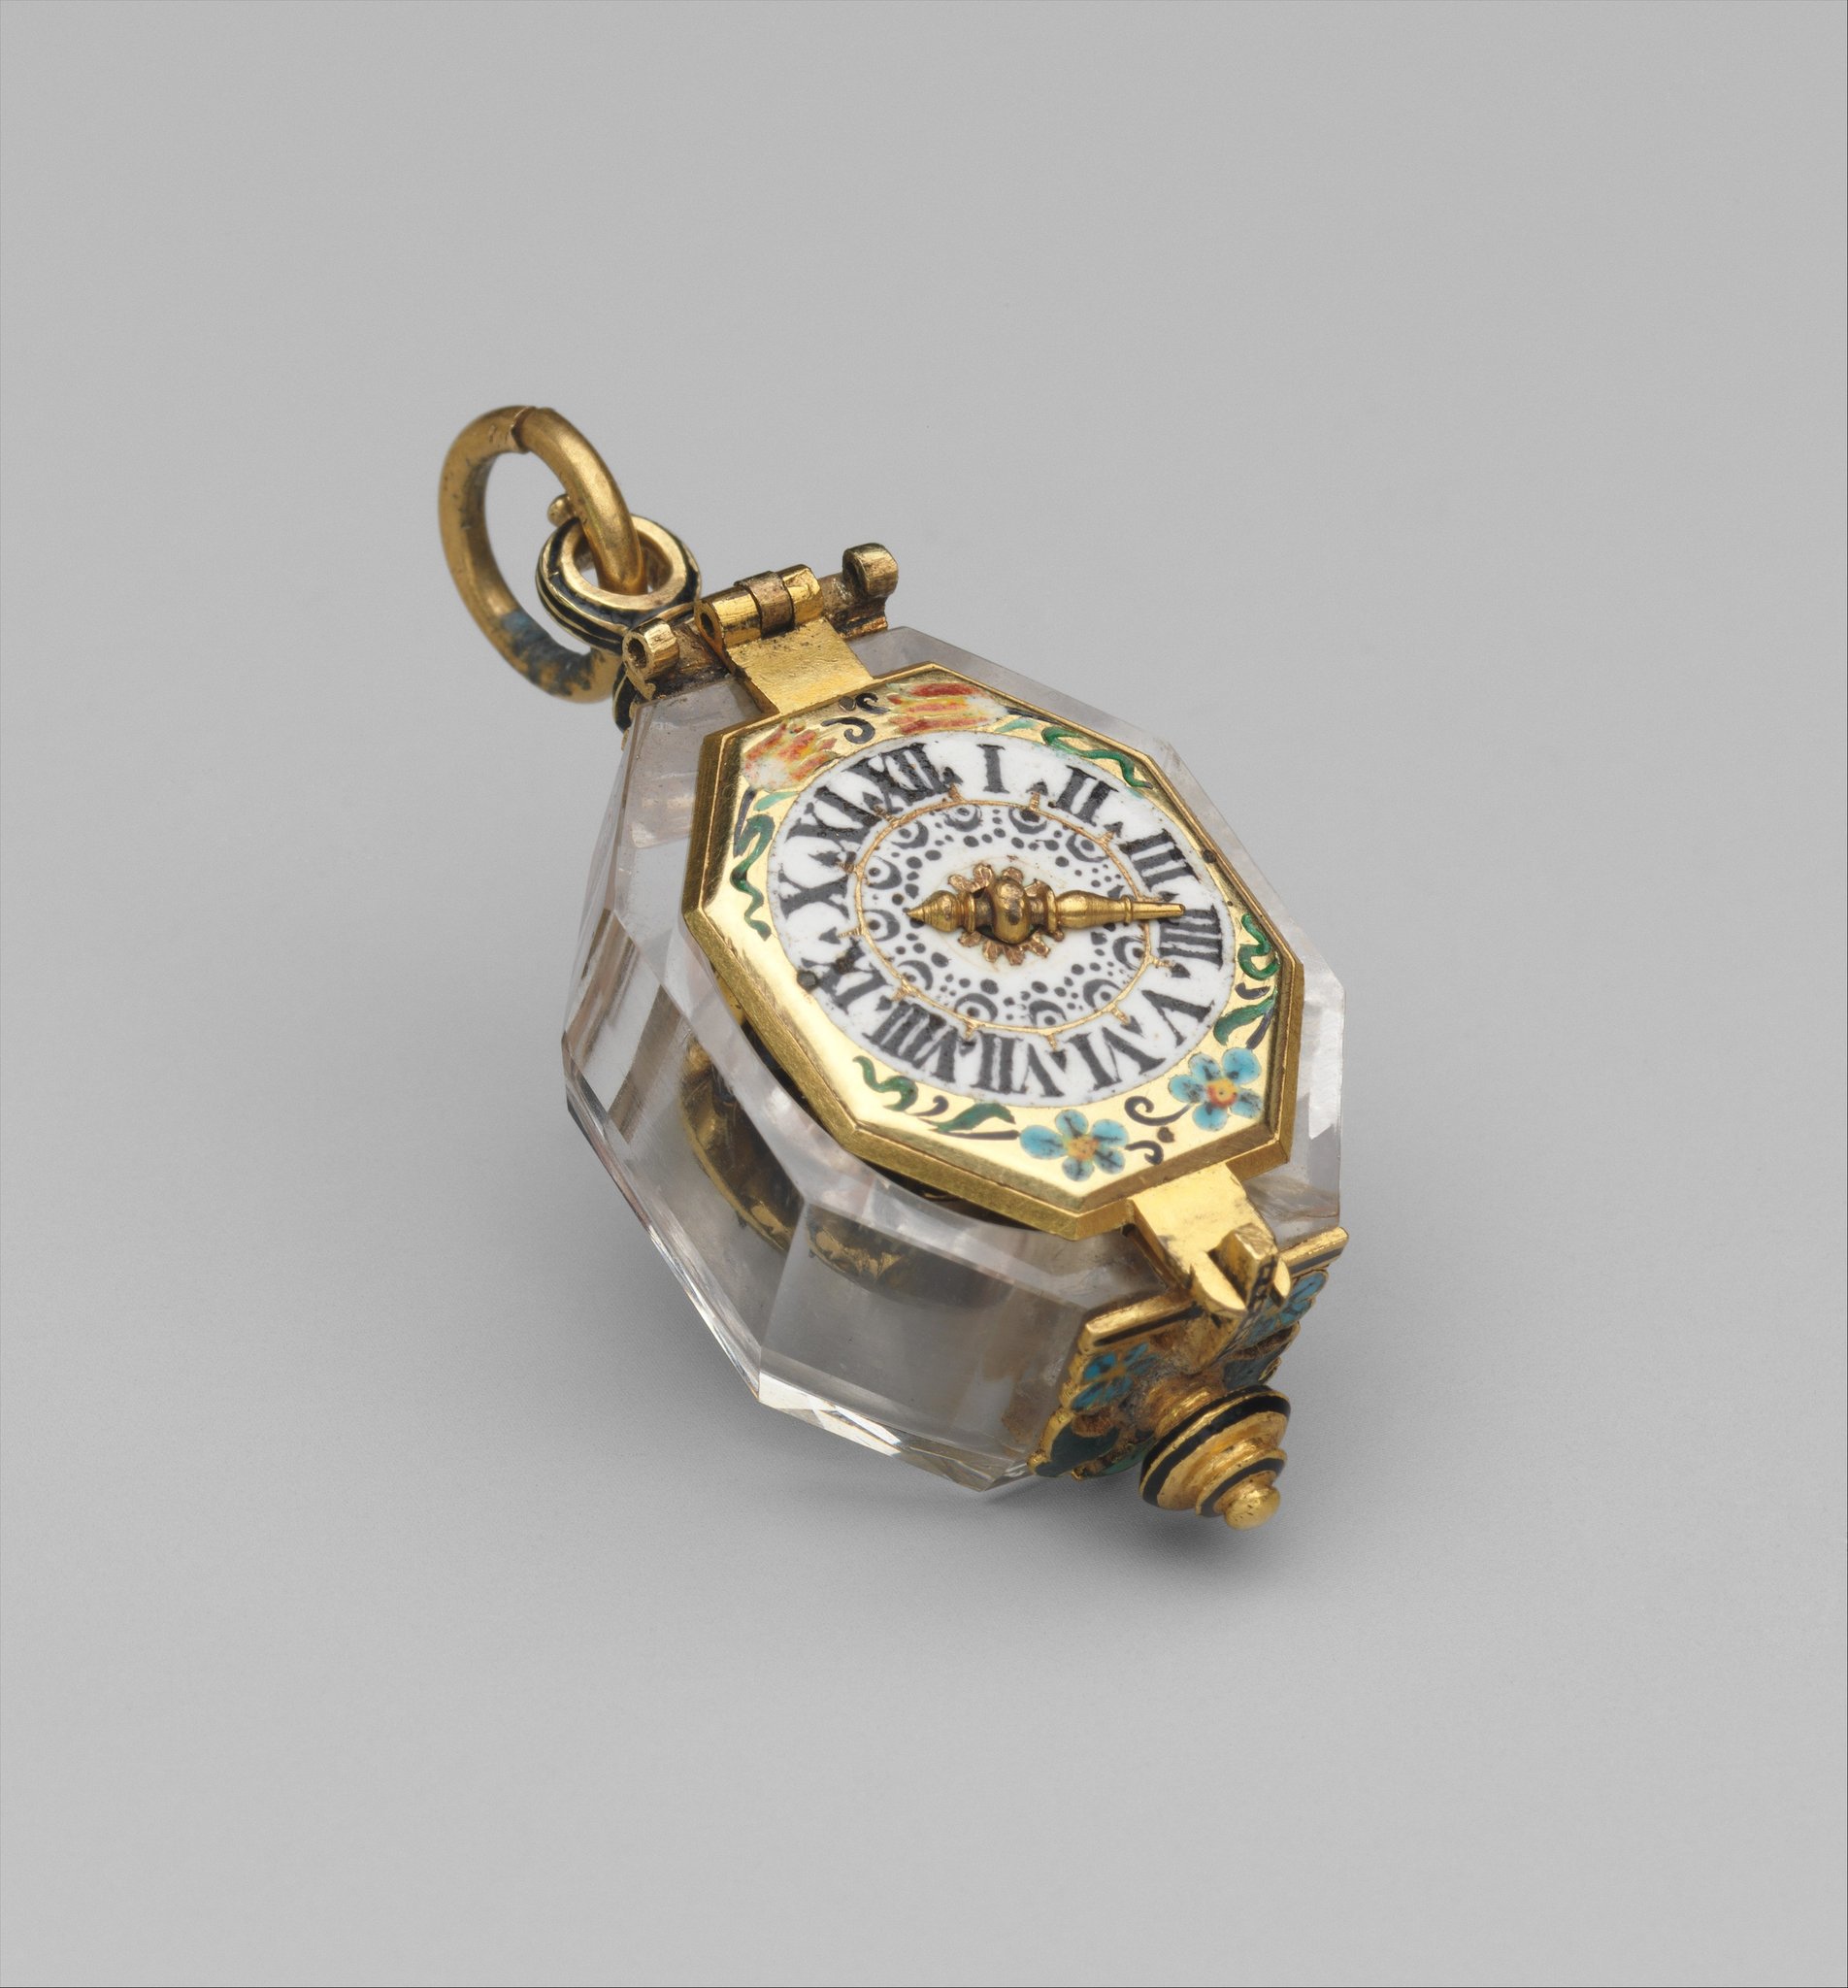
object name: watch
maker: johann possdorfer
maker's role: maker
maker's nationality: german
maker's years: 1590-1654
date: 1630-1640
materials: gilt brass, gold, quartz, steel